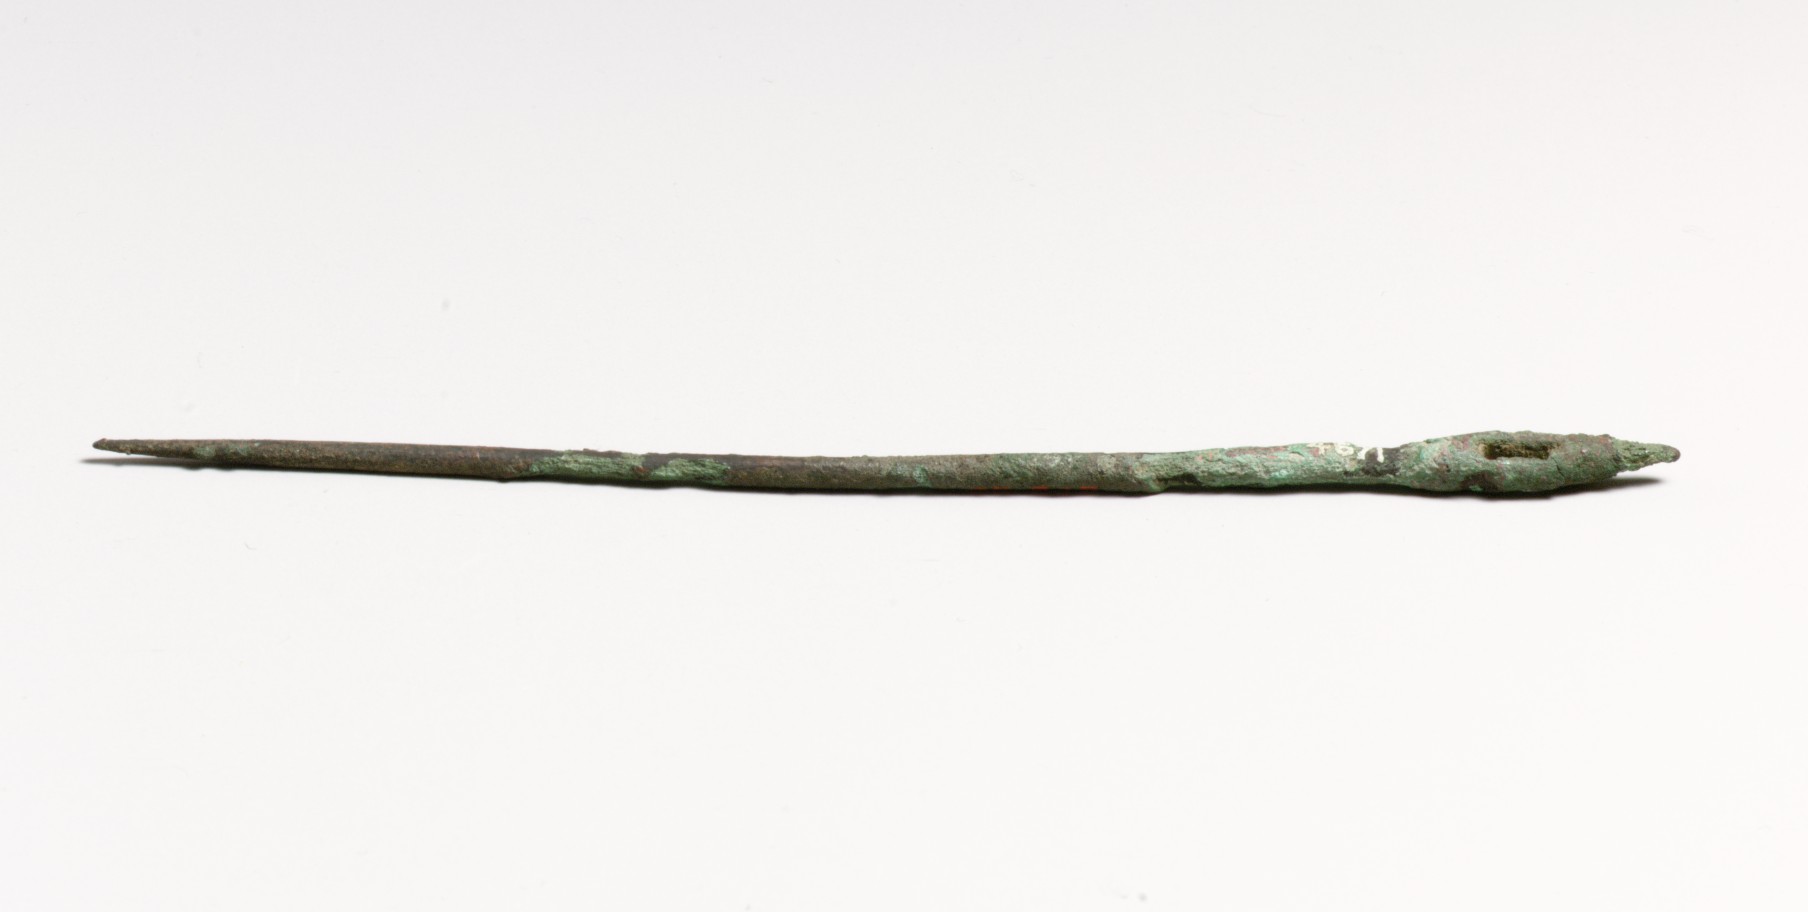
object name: needle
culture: cypriot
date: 3900 BCE-100 CE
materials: bronze